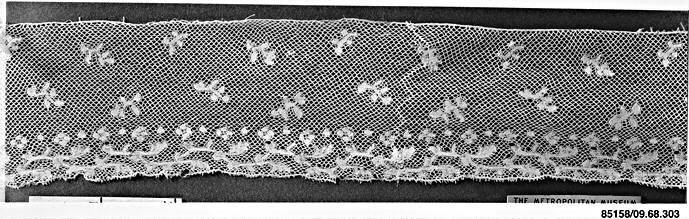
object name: strip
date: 1767-1800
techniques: lace